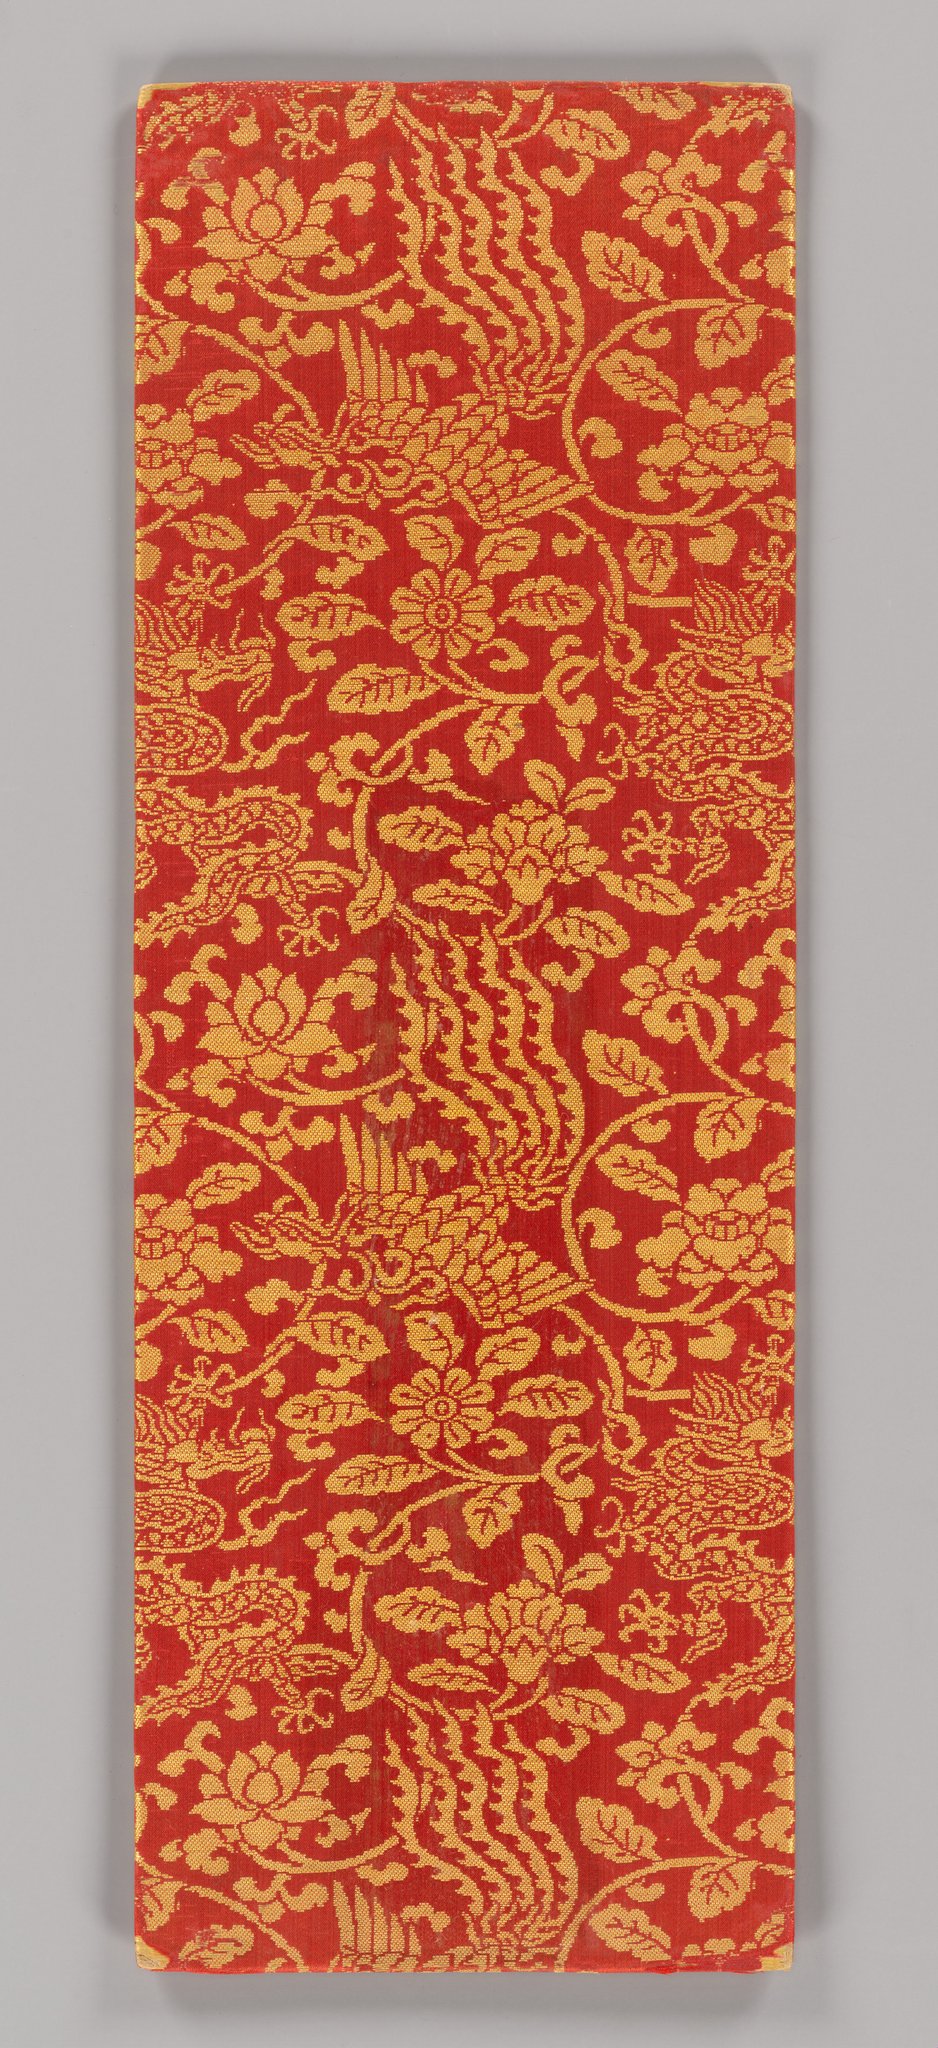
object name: sutra cover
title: Sutra Cover with Dragons and Phoenixes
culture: chinese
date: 1501-1600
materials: silk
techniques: patterning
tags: dragons,phoenix